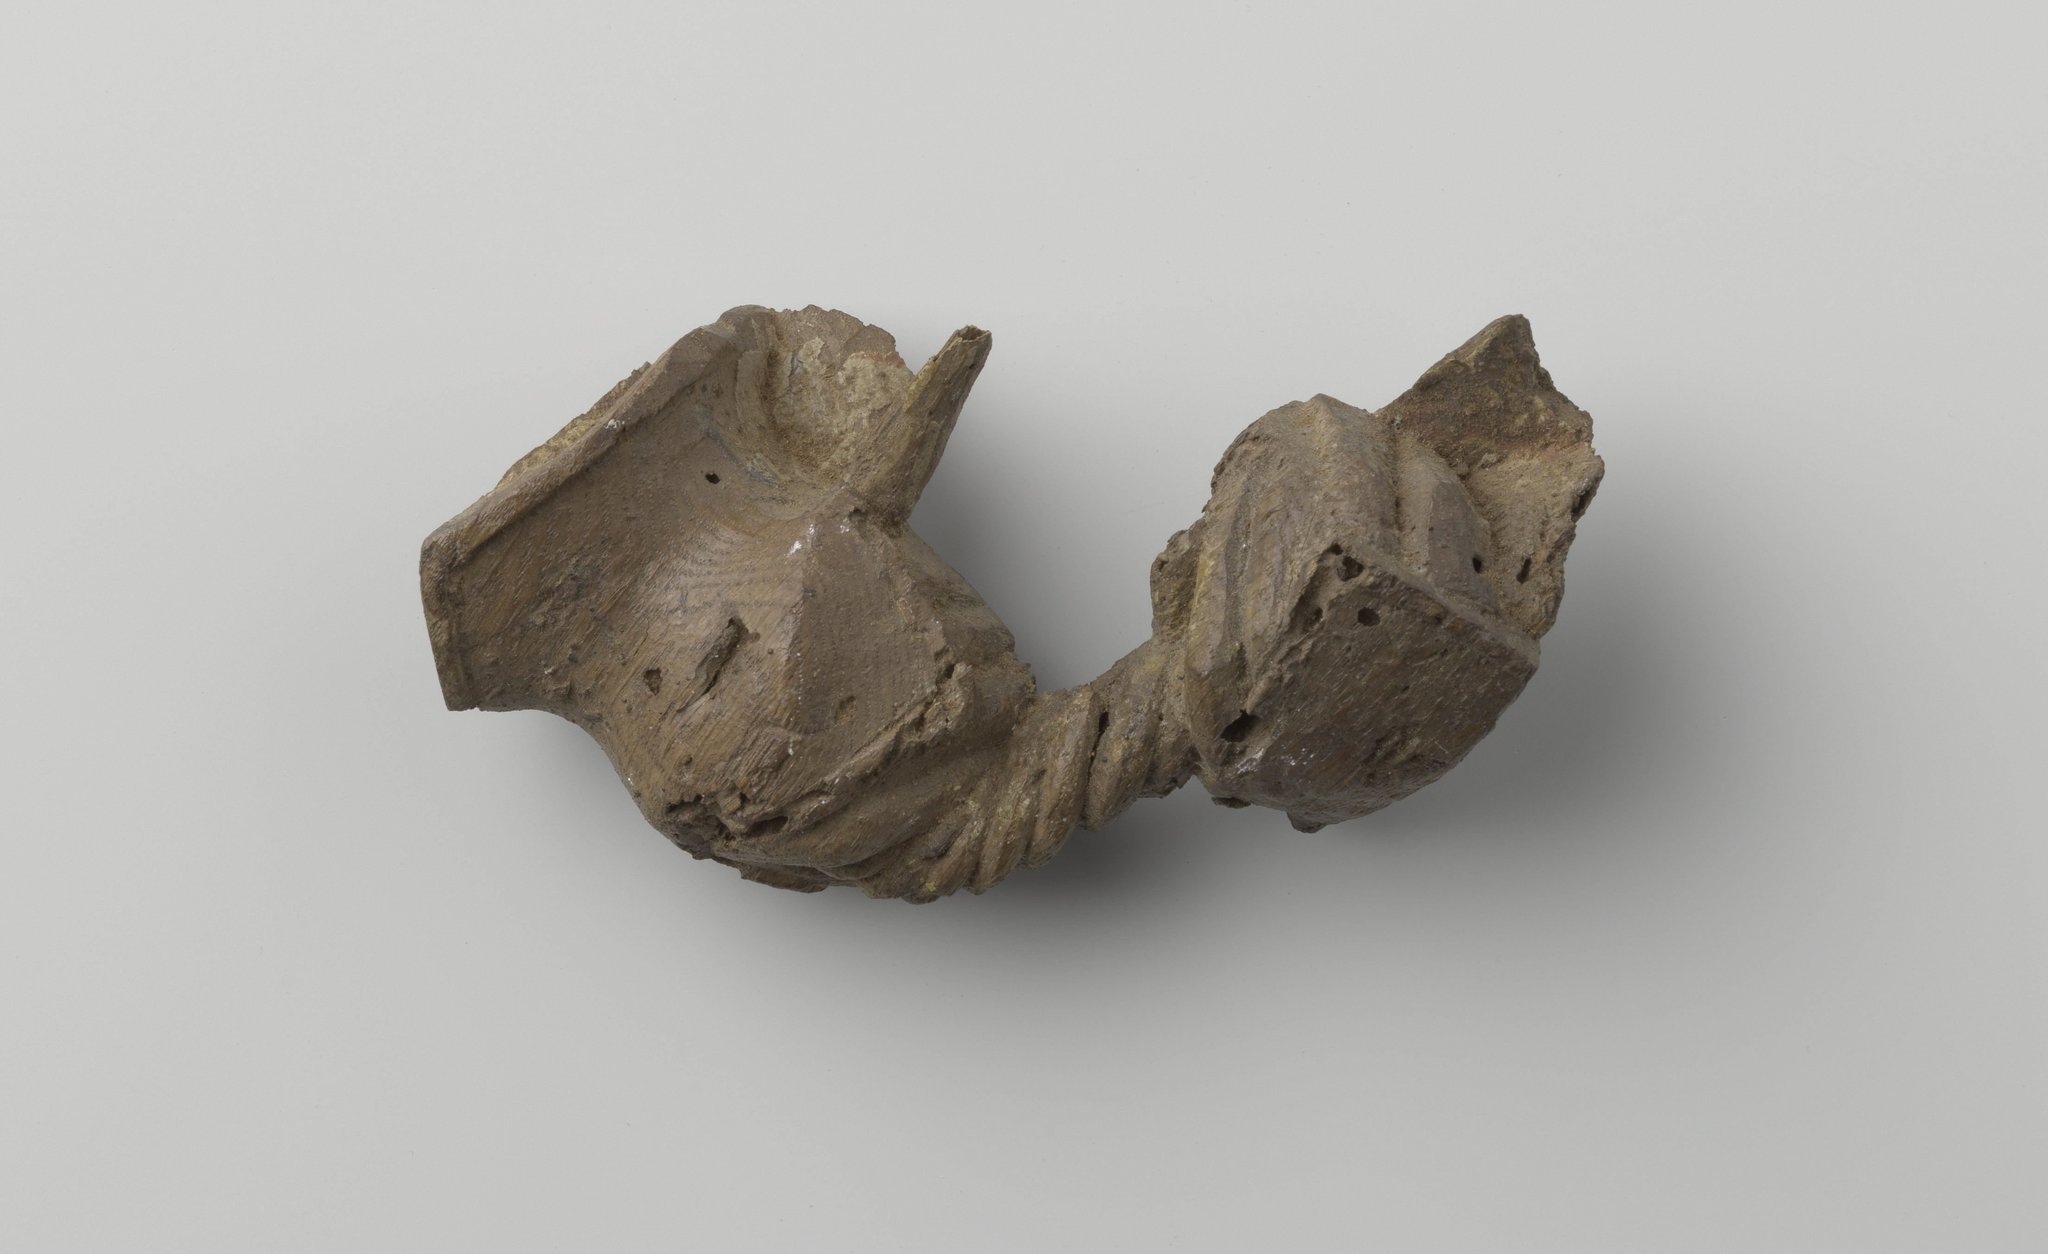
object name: sculpture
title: Hands of a Soldier with a Piece of Rope, from Christ Carrying the Cross, from the Soest Altarpiece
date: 1475-1499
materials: wood